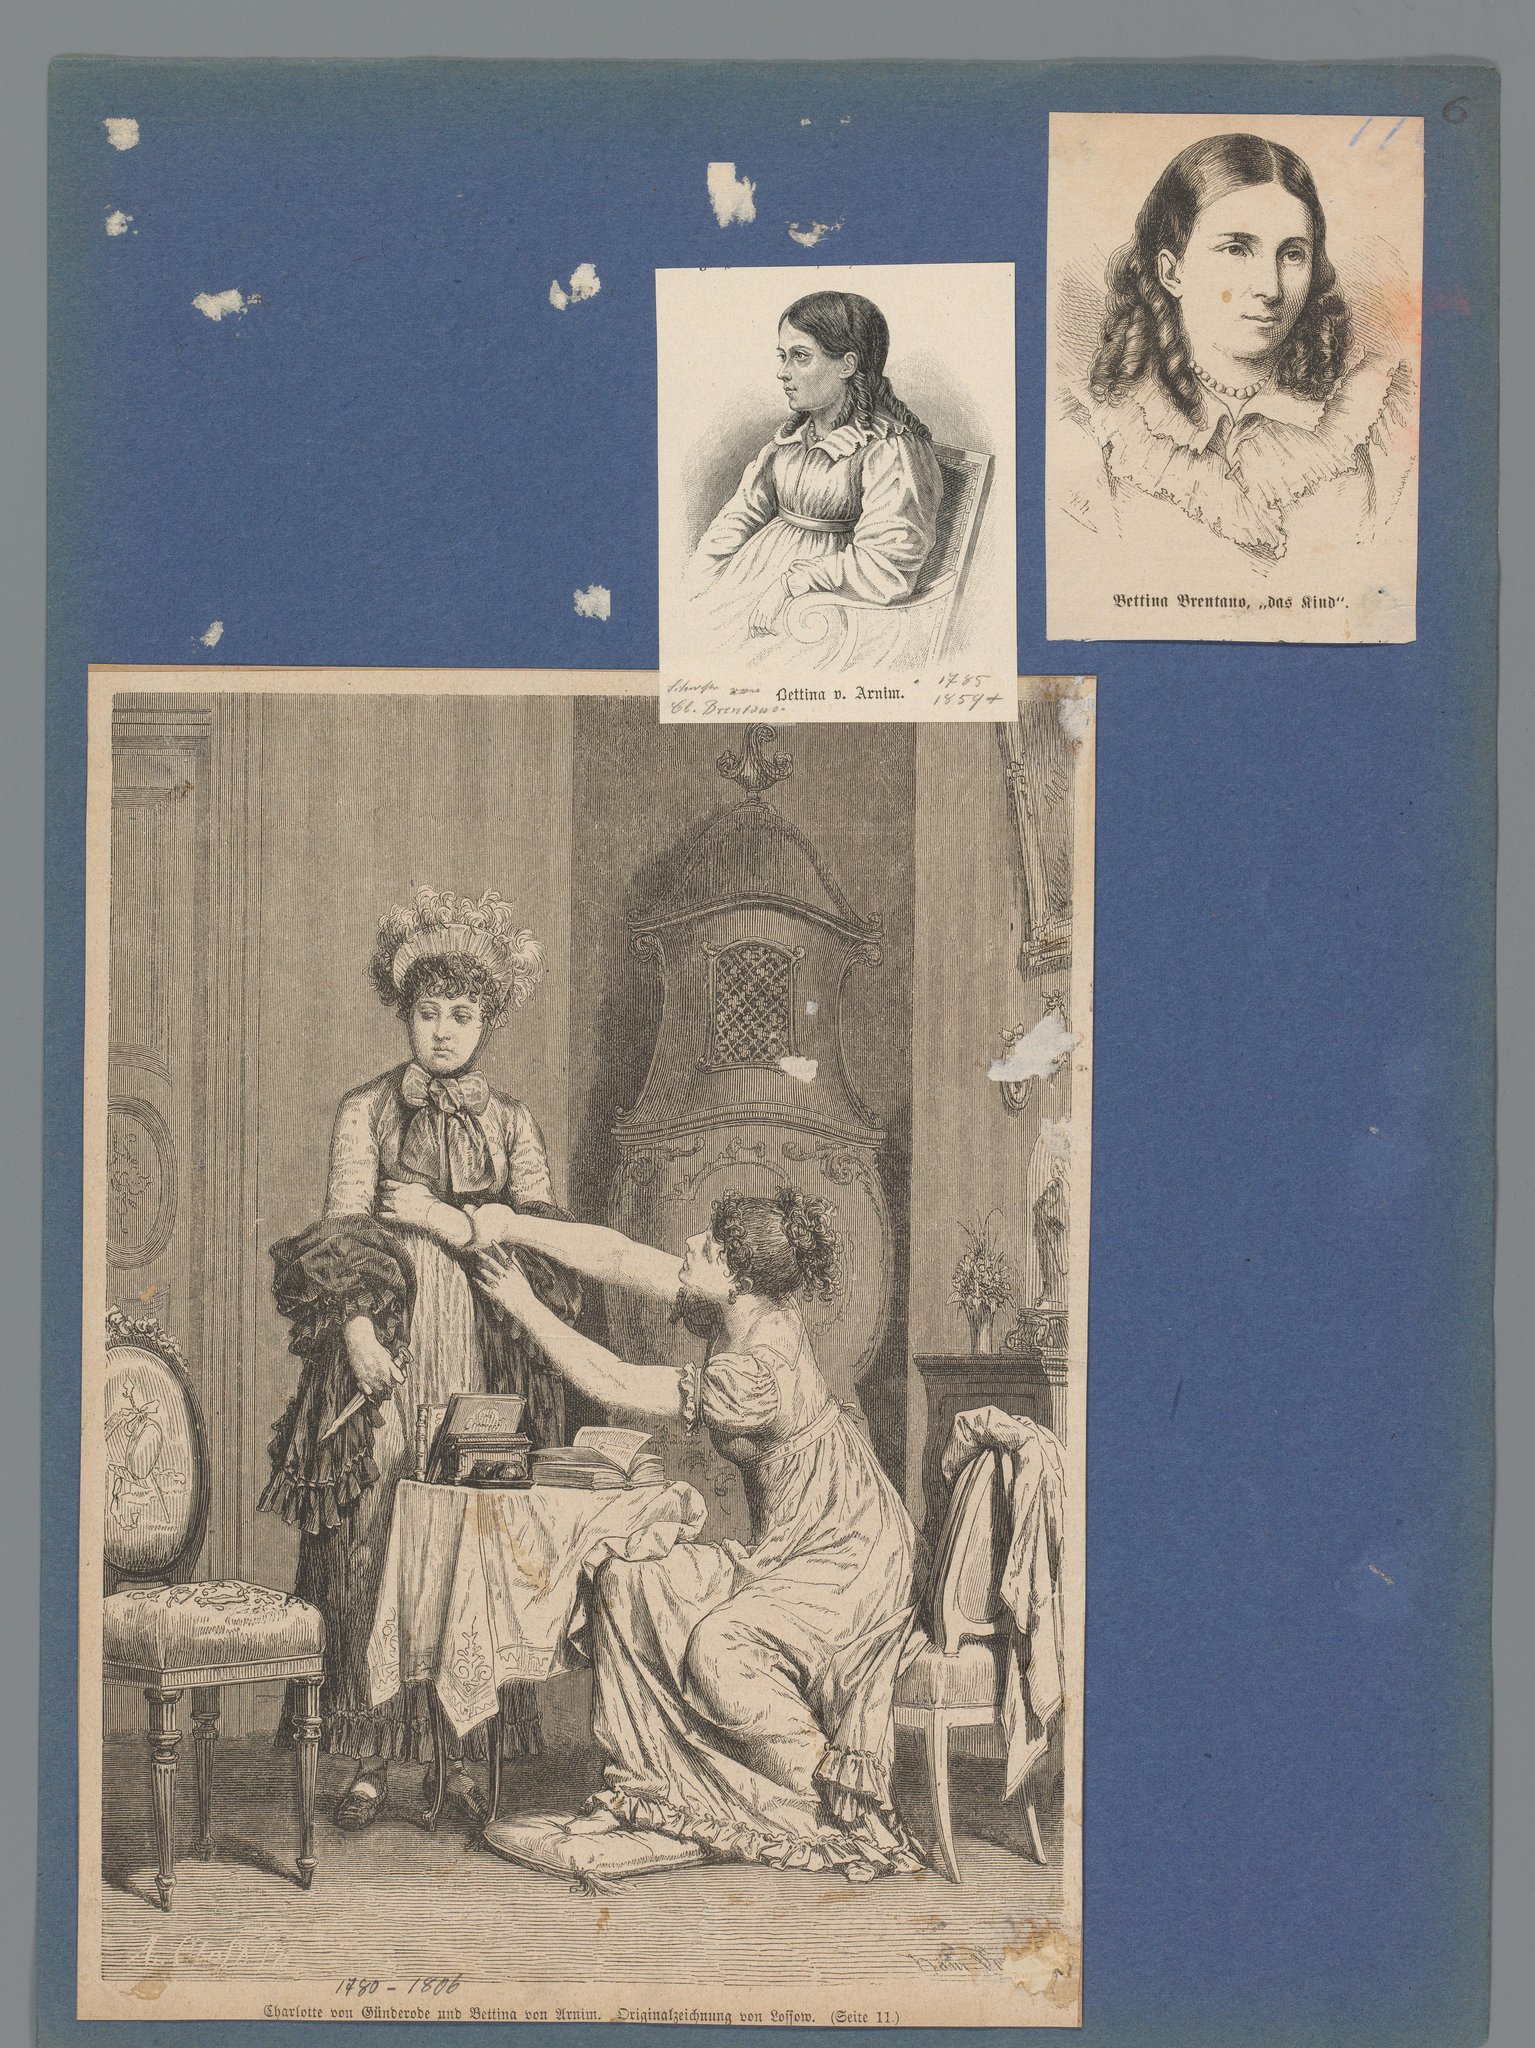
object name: sheet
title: Blad met één portret van Charlotte von Günderrode en twee van Bettina von Arnim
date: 1850-1900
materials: paper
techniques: snipping, engraving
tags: charlotte von günderrode, berlin, historical persons - bb - woman, portrait of a writer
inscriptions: signature: ‘A alofs sc.’, number: ‘3.’, signature: ‘H h’